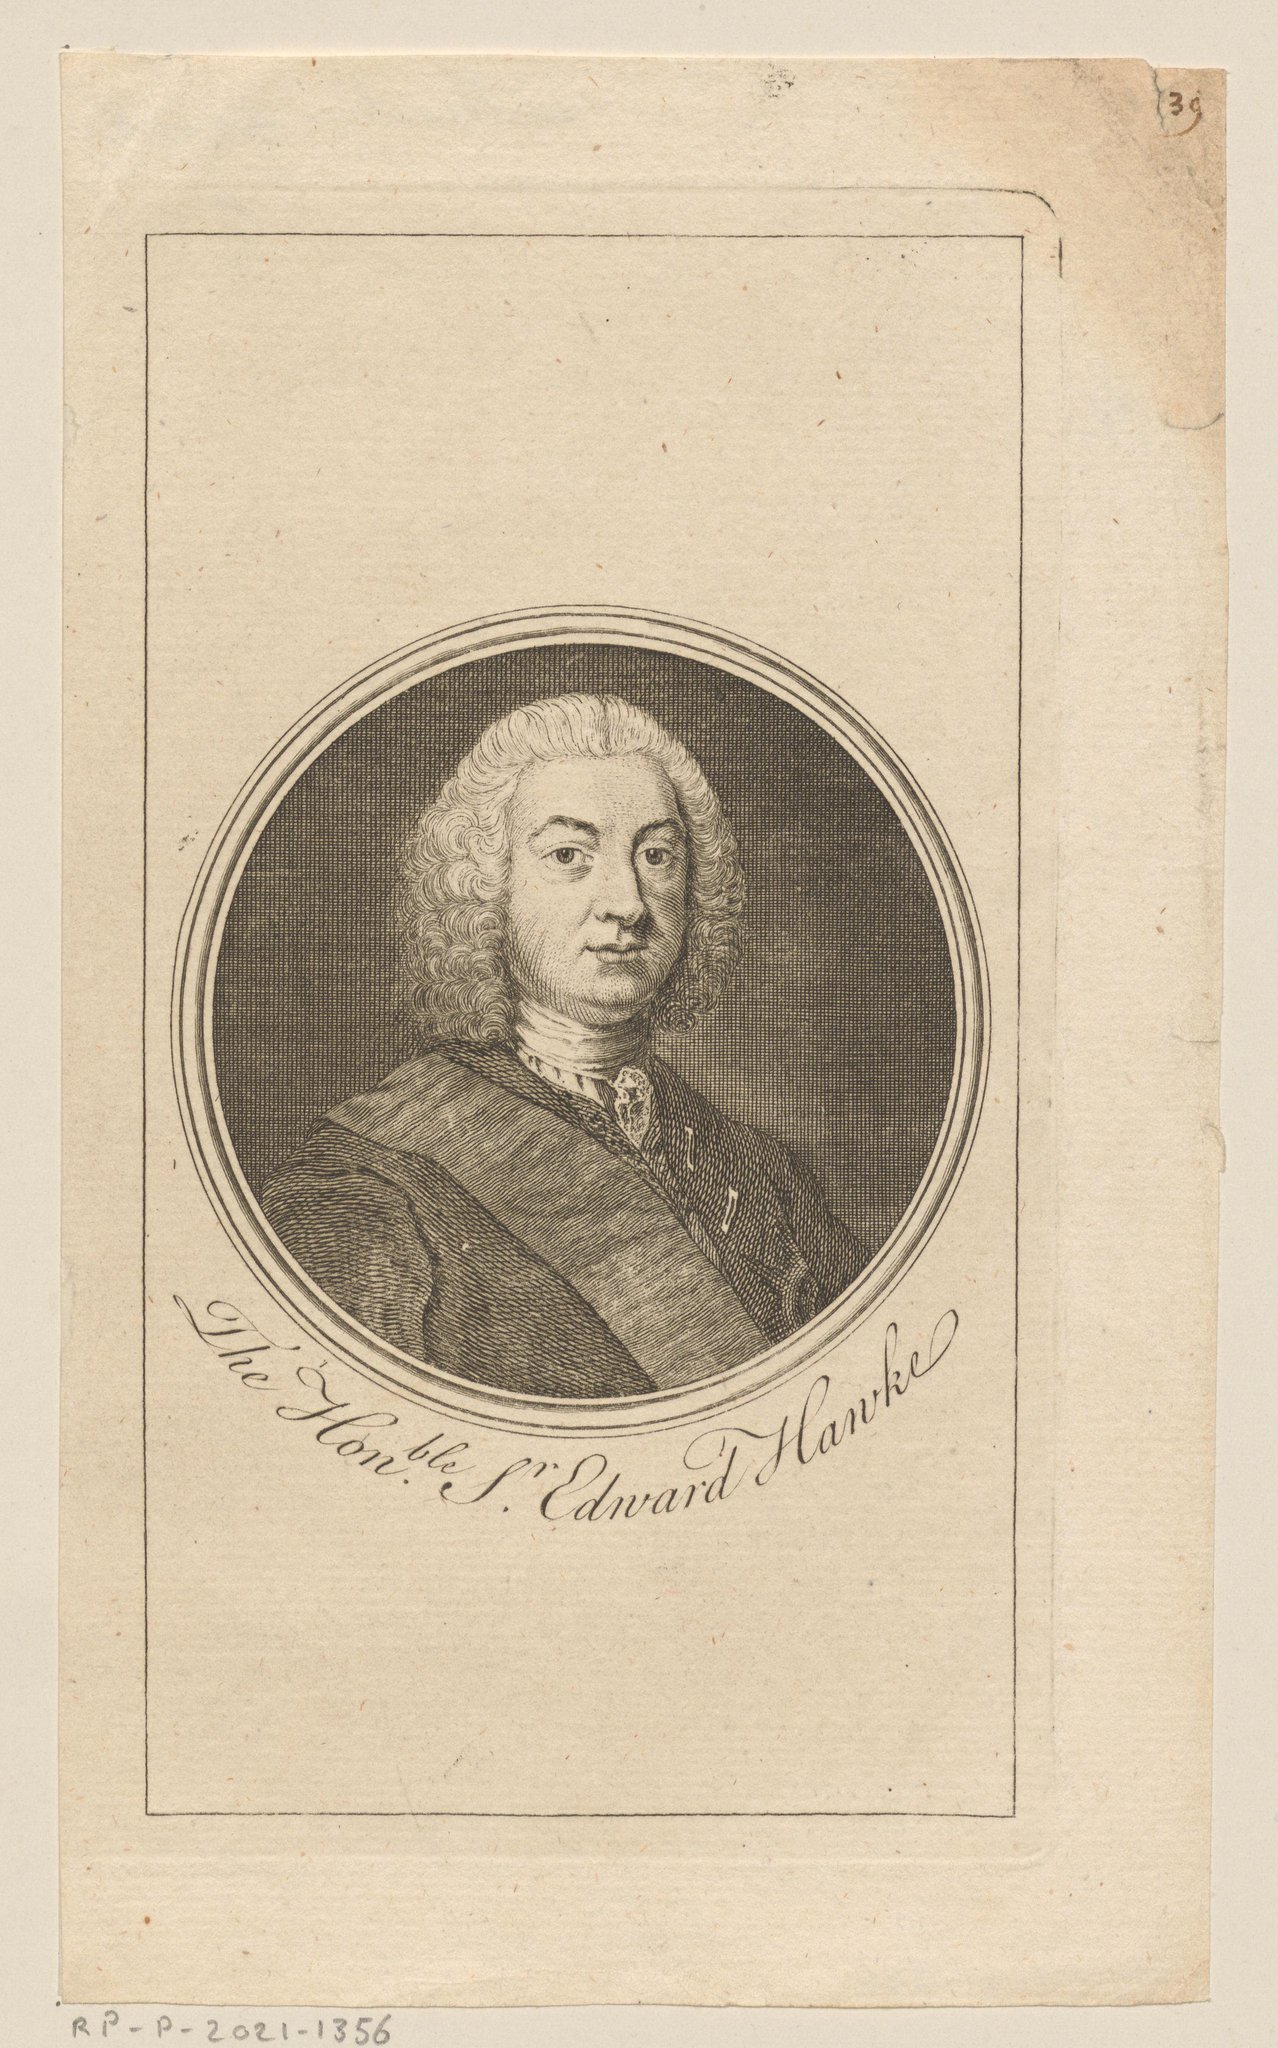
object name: print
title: Portret van Edward Hawke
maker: Anonymous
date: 1775-1799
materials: paper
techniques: engraving, etching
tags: edward hawke (1e baron hawke), historical persons, commander-in-chief, admiral